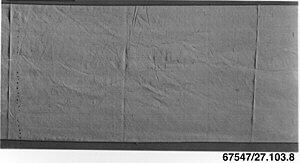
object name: ribbon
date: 1865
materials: silk